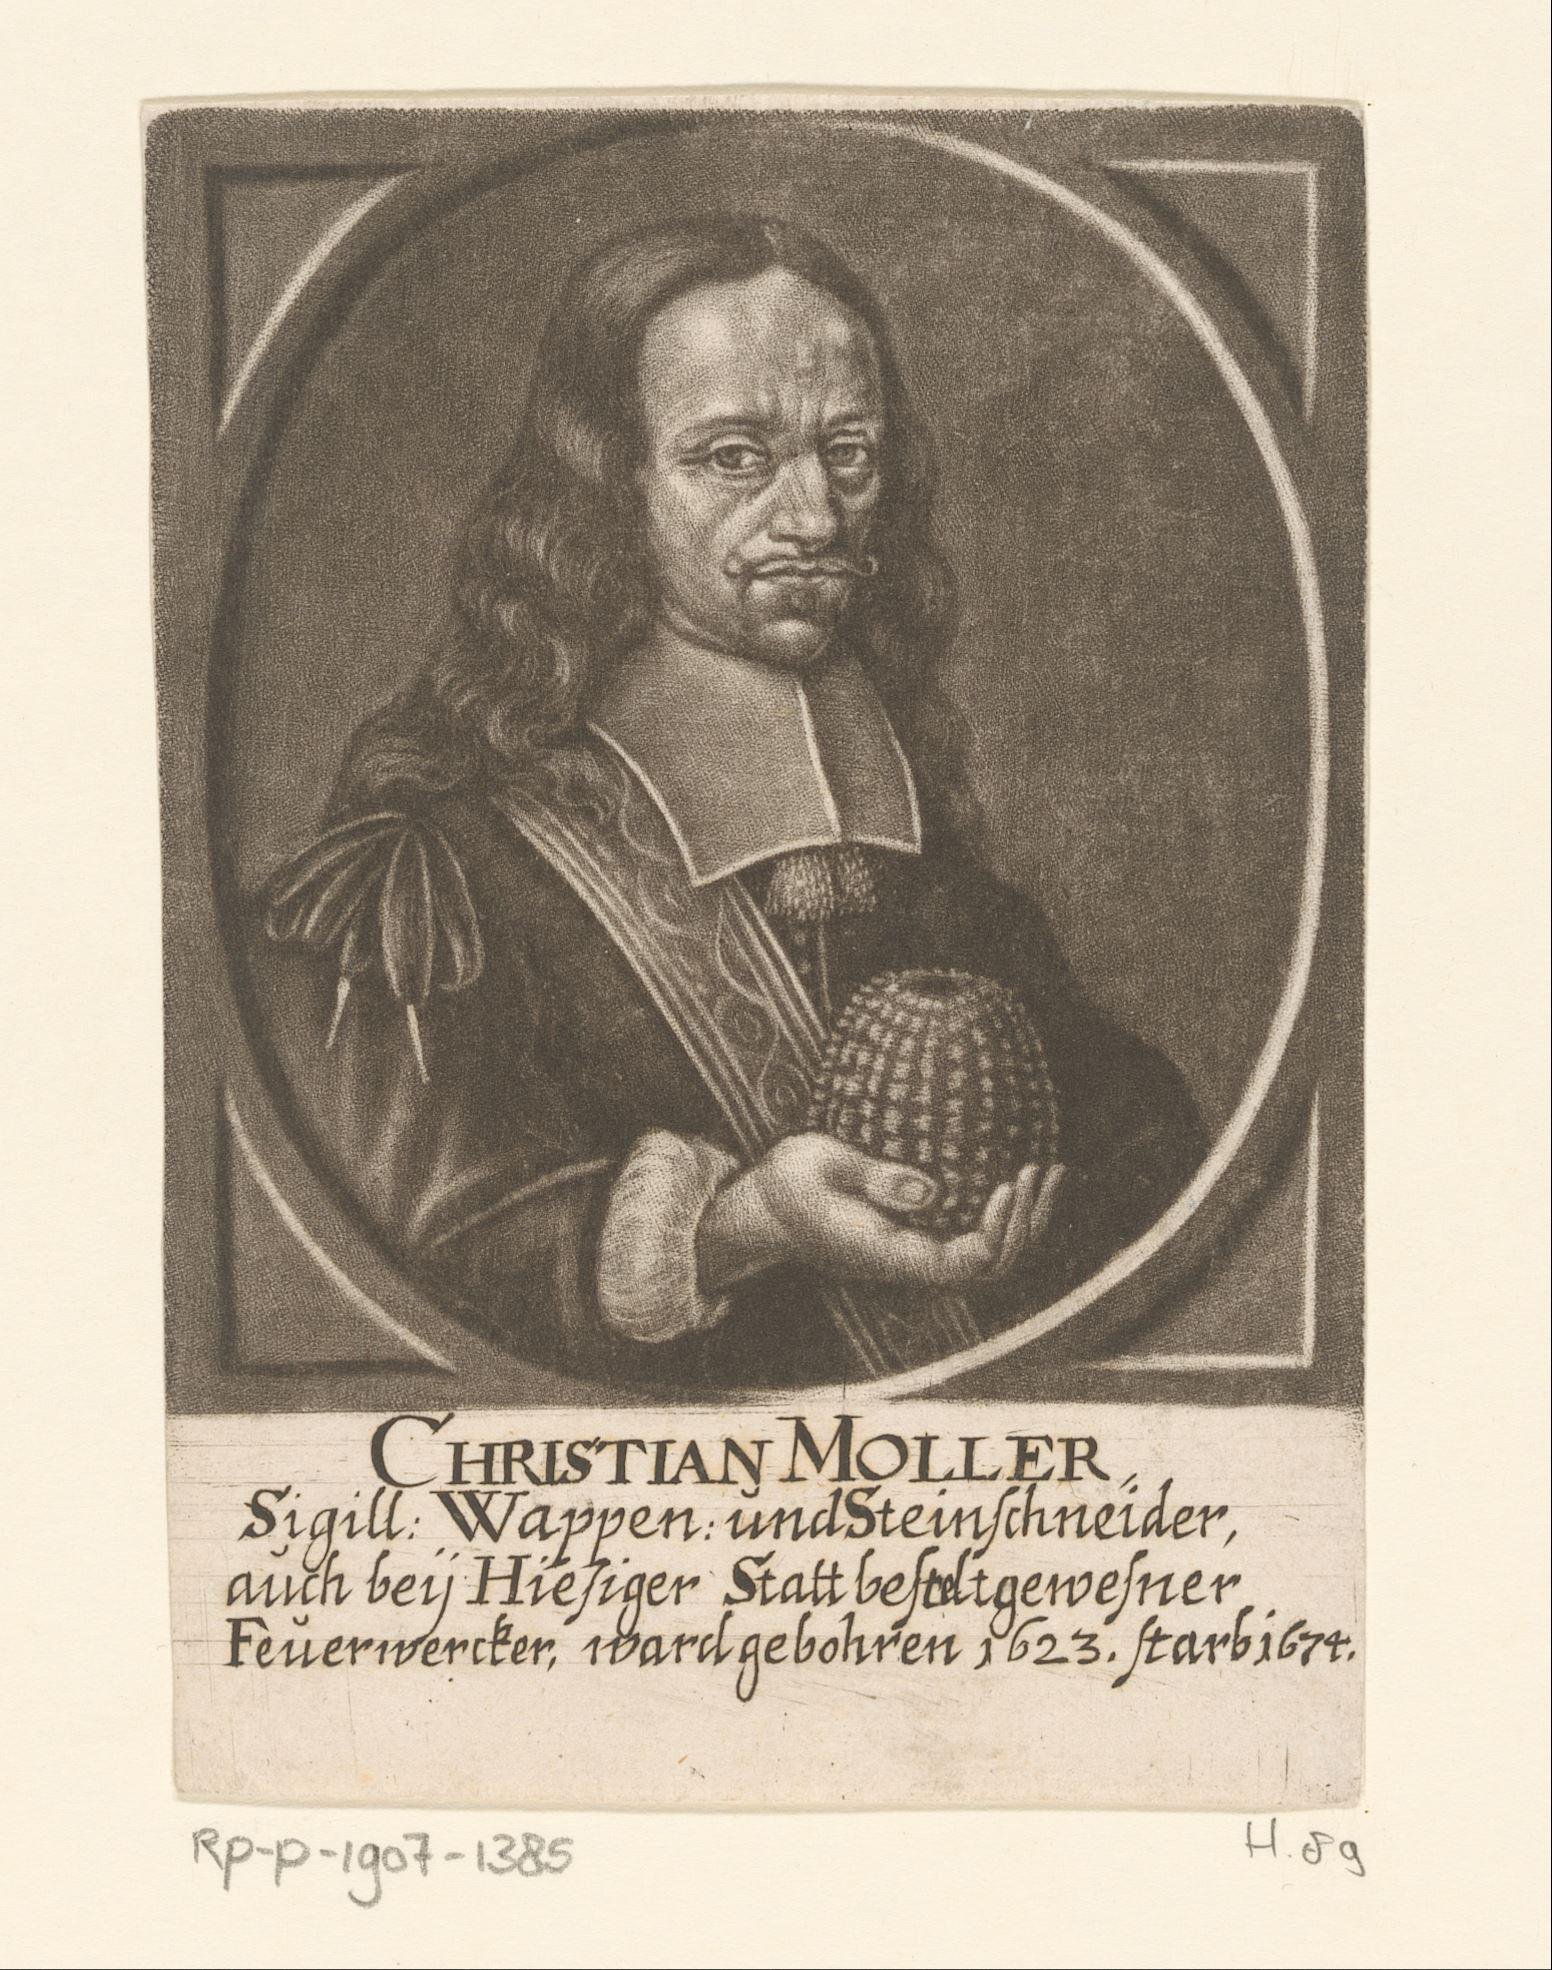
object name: print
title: Portret van Christian Moller met vuurwerk in de hand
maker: georg fennitzer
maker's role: print maker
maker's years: 1646-1722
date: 1674-1722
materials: paper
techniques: mezzotint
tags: carving ~ applied arts, historical persons, bonfire, fire-works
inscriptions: collector's mark: Lugt 2228